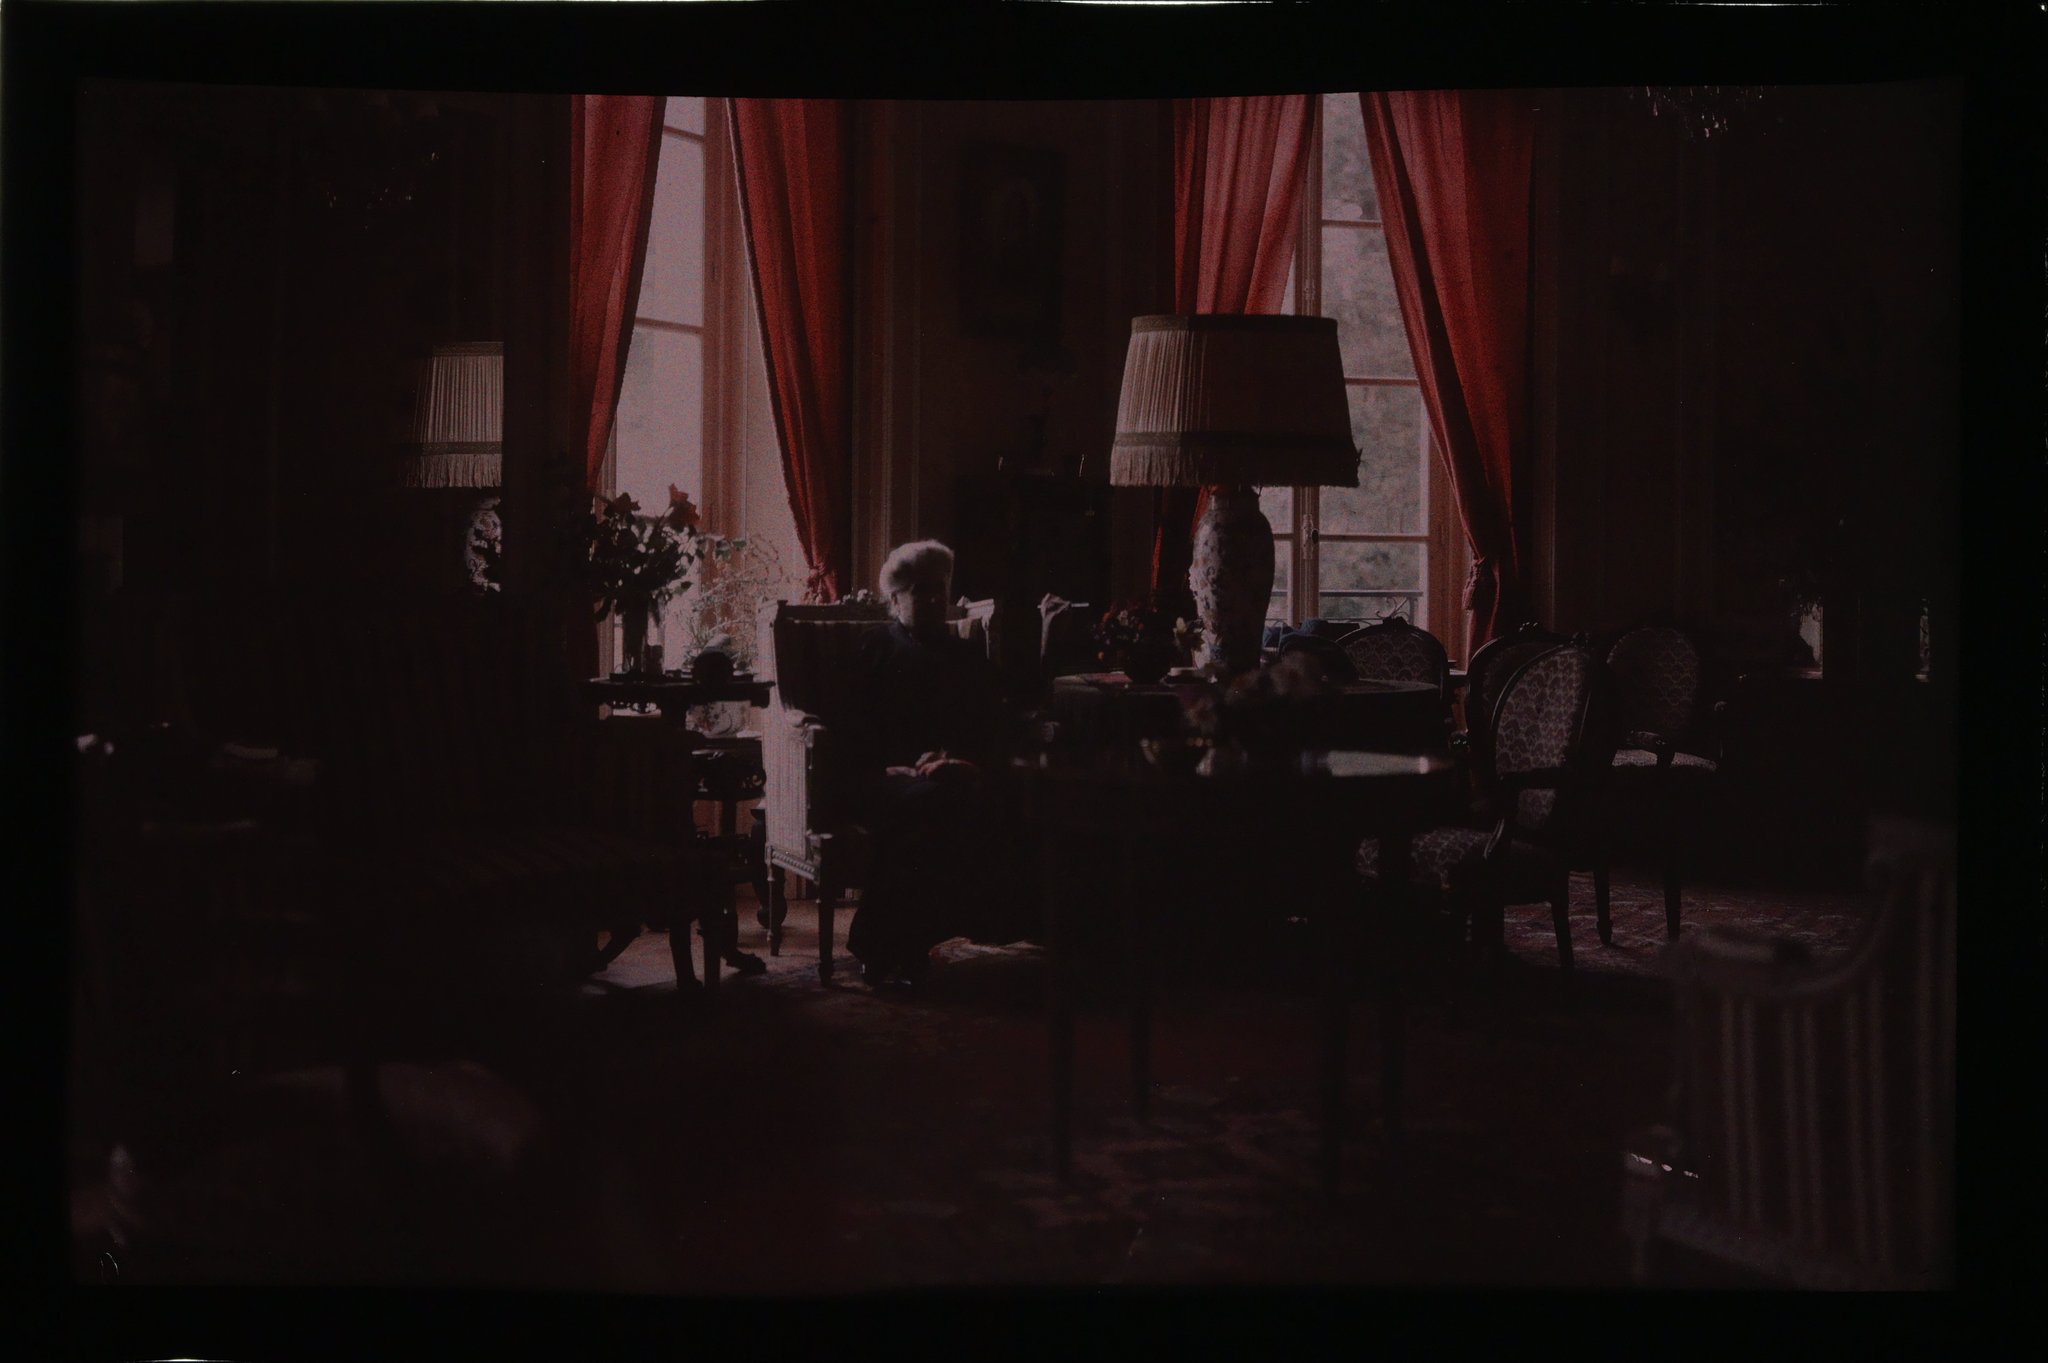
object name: photograph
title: Interieur, met dame gezeten in een fauteuil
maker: Anonymous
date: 1910-1940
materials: glass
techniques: autochrome process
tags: interior of the house